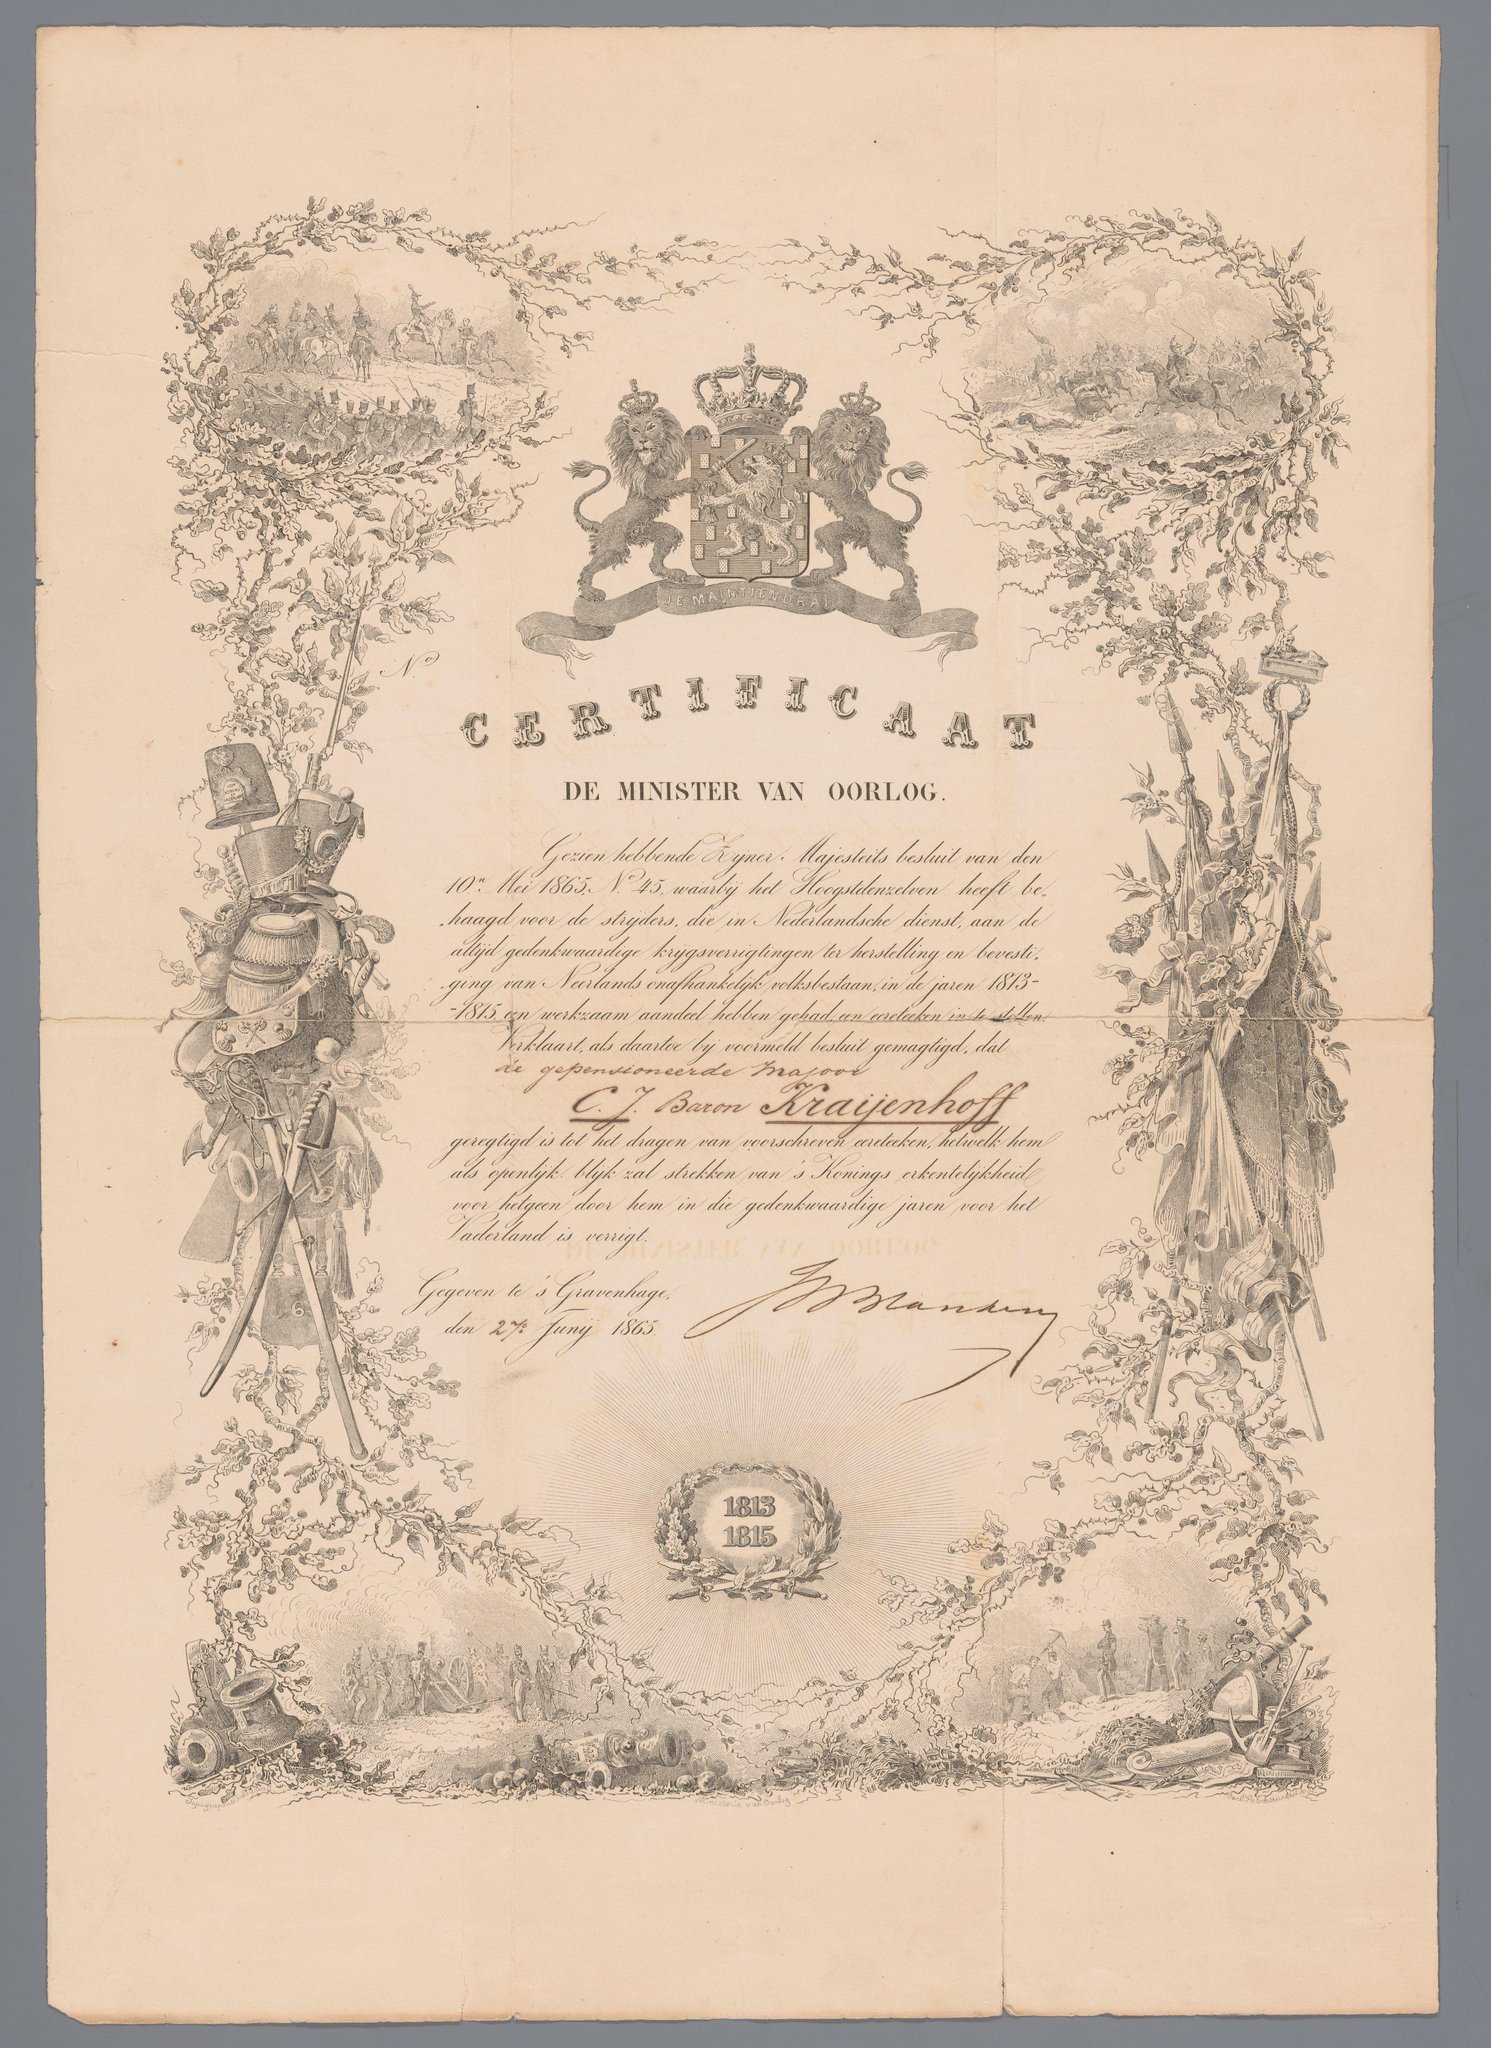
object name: document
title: Certificaat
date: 1865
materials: ink, paper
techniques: printing, writing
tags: c.j. baron krayenhoff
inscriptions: signature and date